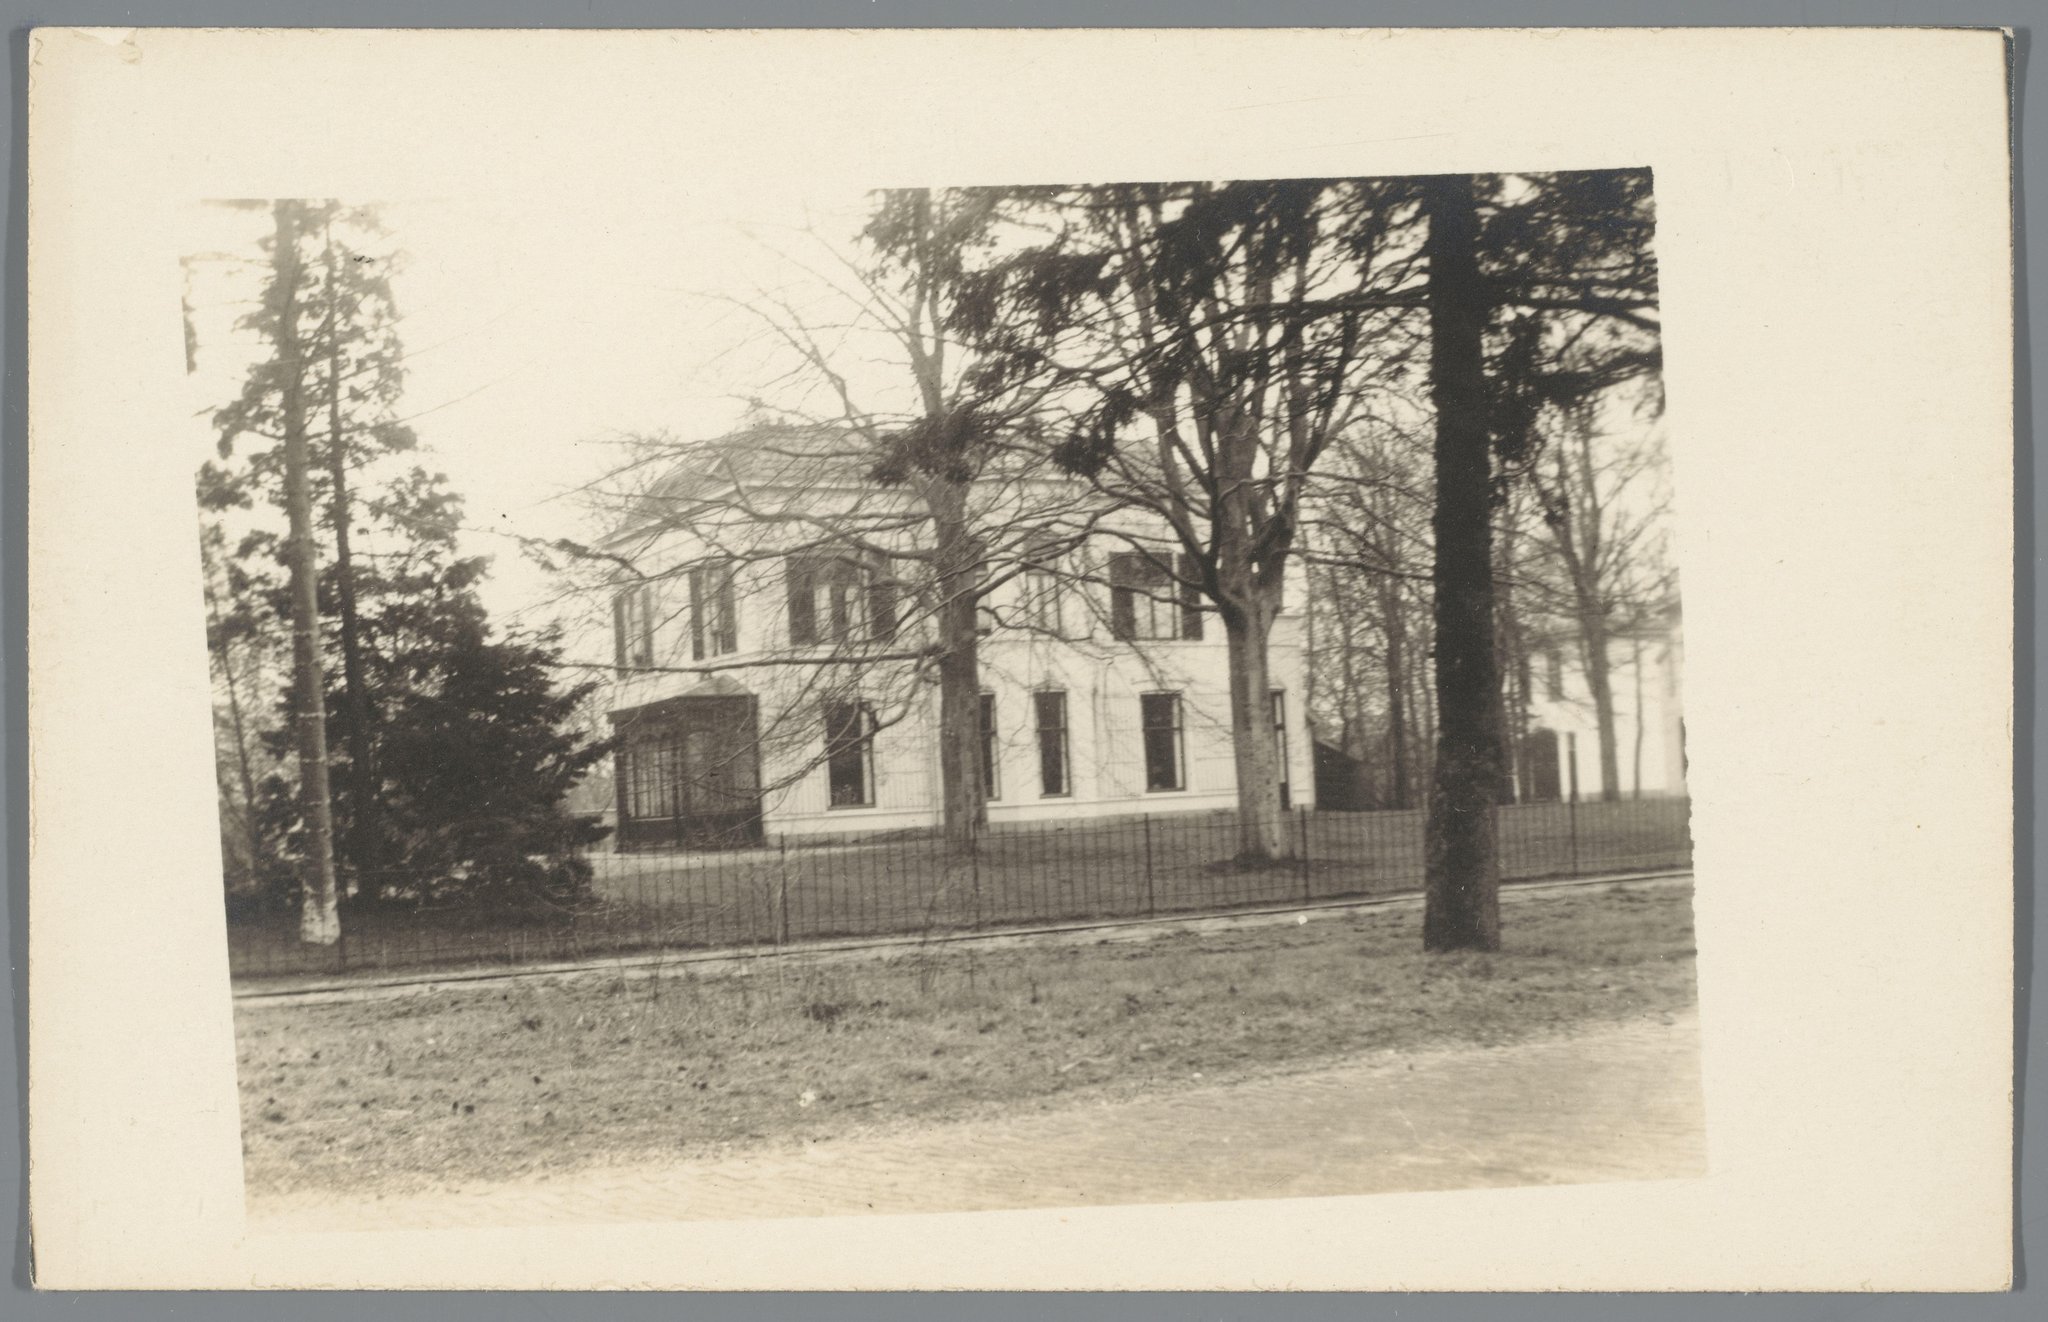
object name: photograph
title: Gezicht op een villa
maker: cornelia hendrika jonker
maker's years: 1874-1924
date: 1910-1950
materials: photographic support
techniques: gelatin silver print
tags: trees, rural housing, e.g. country-house, villa, cottage, villa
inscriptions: number: ‘3088 3’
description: Op verso regels om te versturen als postkaart.